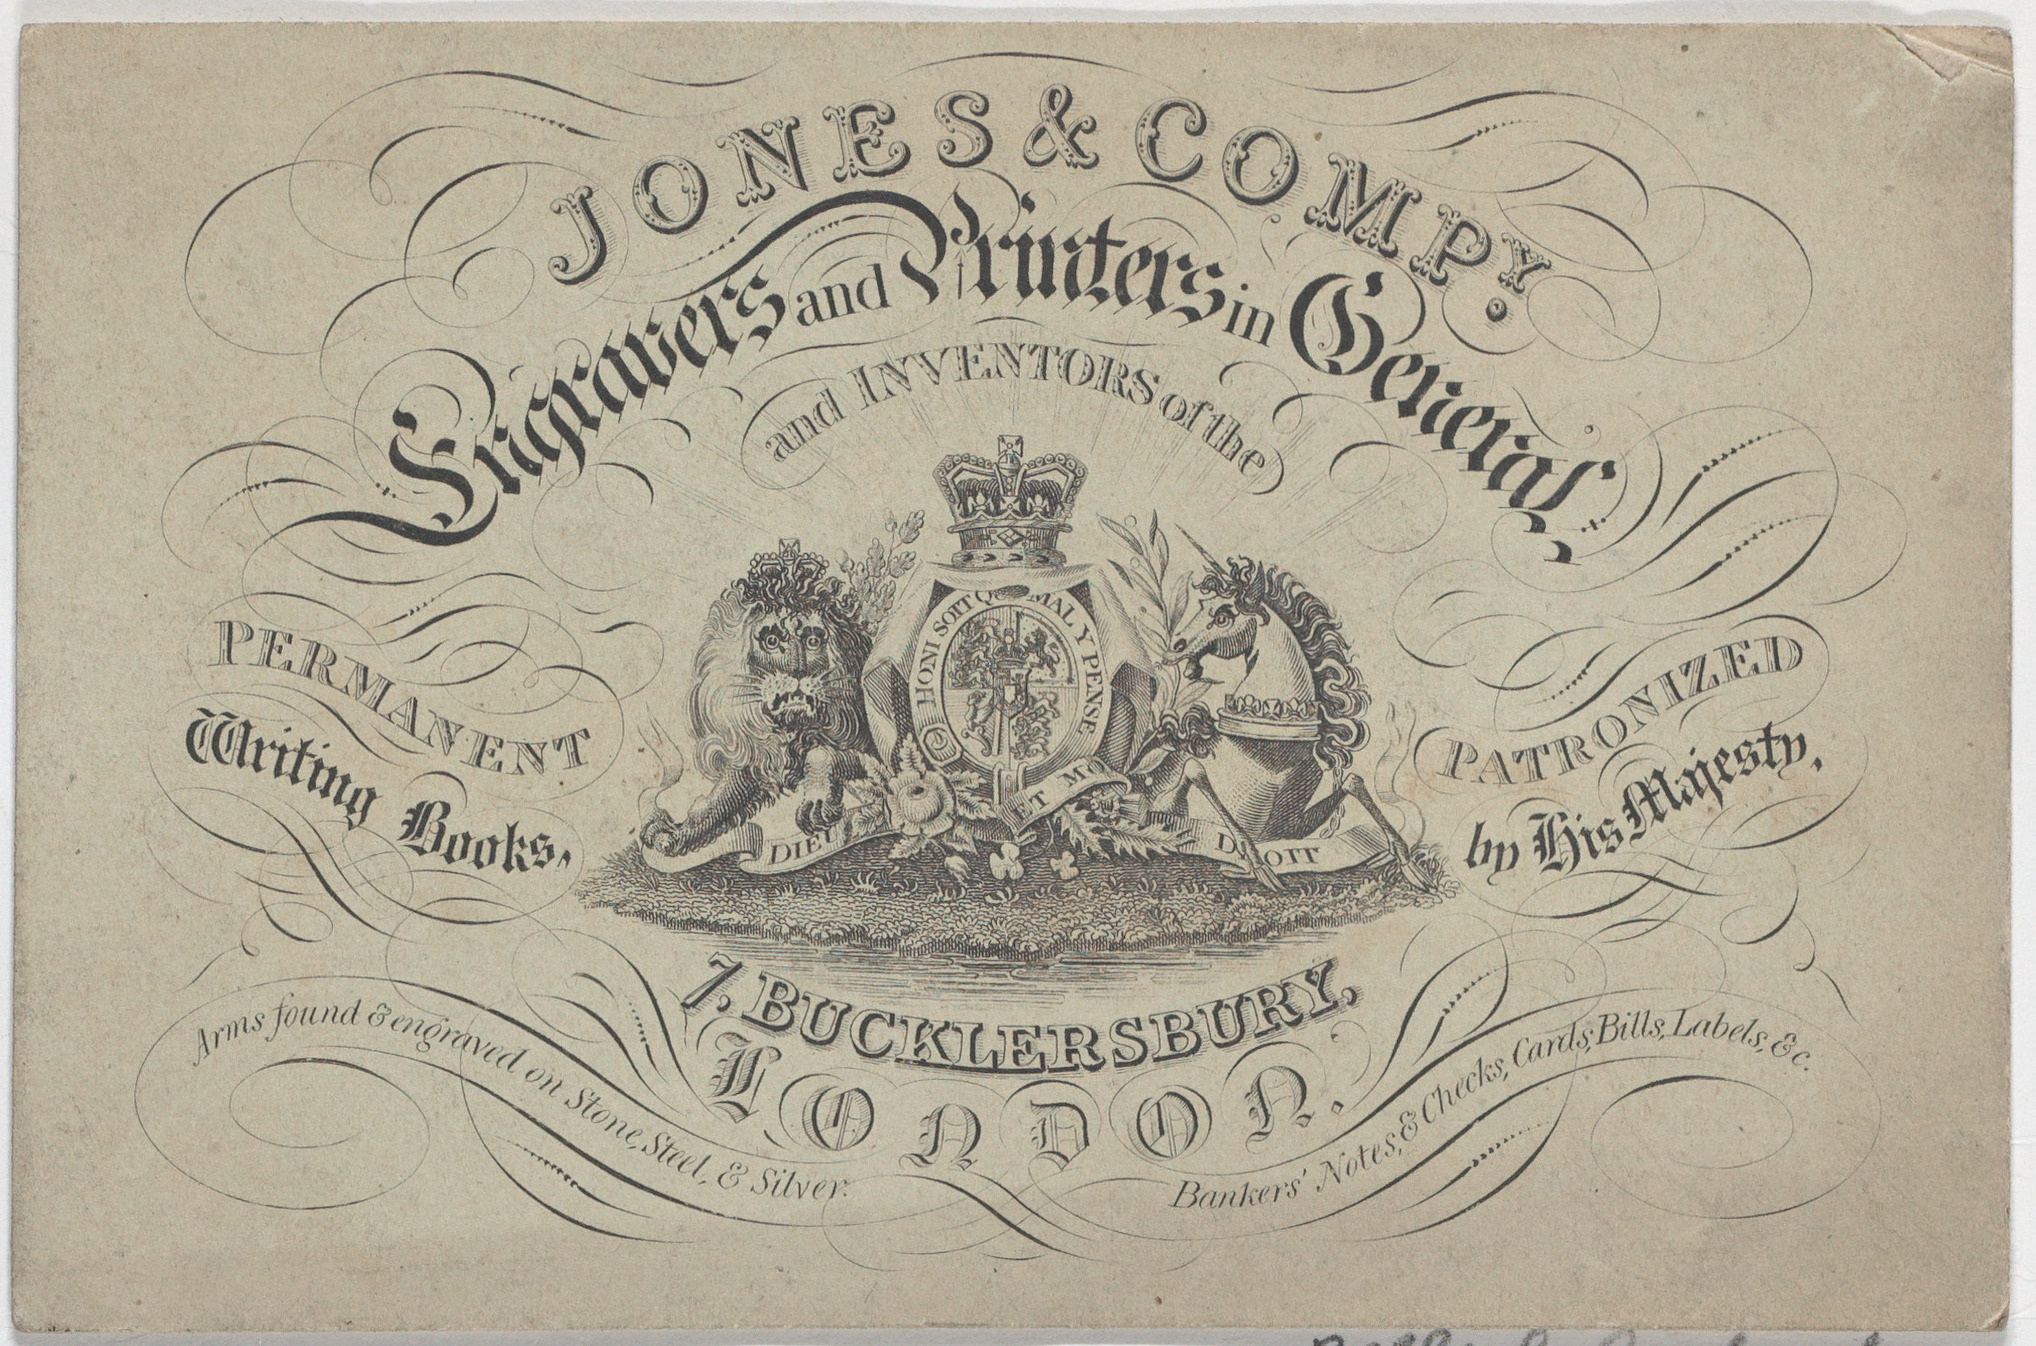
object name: print, trade card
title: Trade Card for Jones & Company, Engravers and Printers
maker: anonymous, british, 18th century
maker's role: artist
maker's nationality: british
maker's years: 1700-1800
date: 1701-1800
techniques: engraving